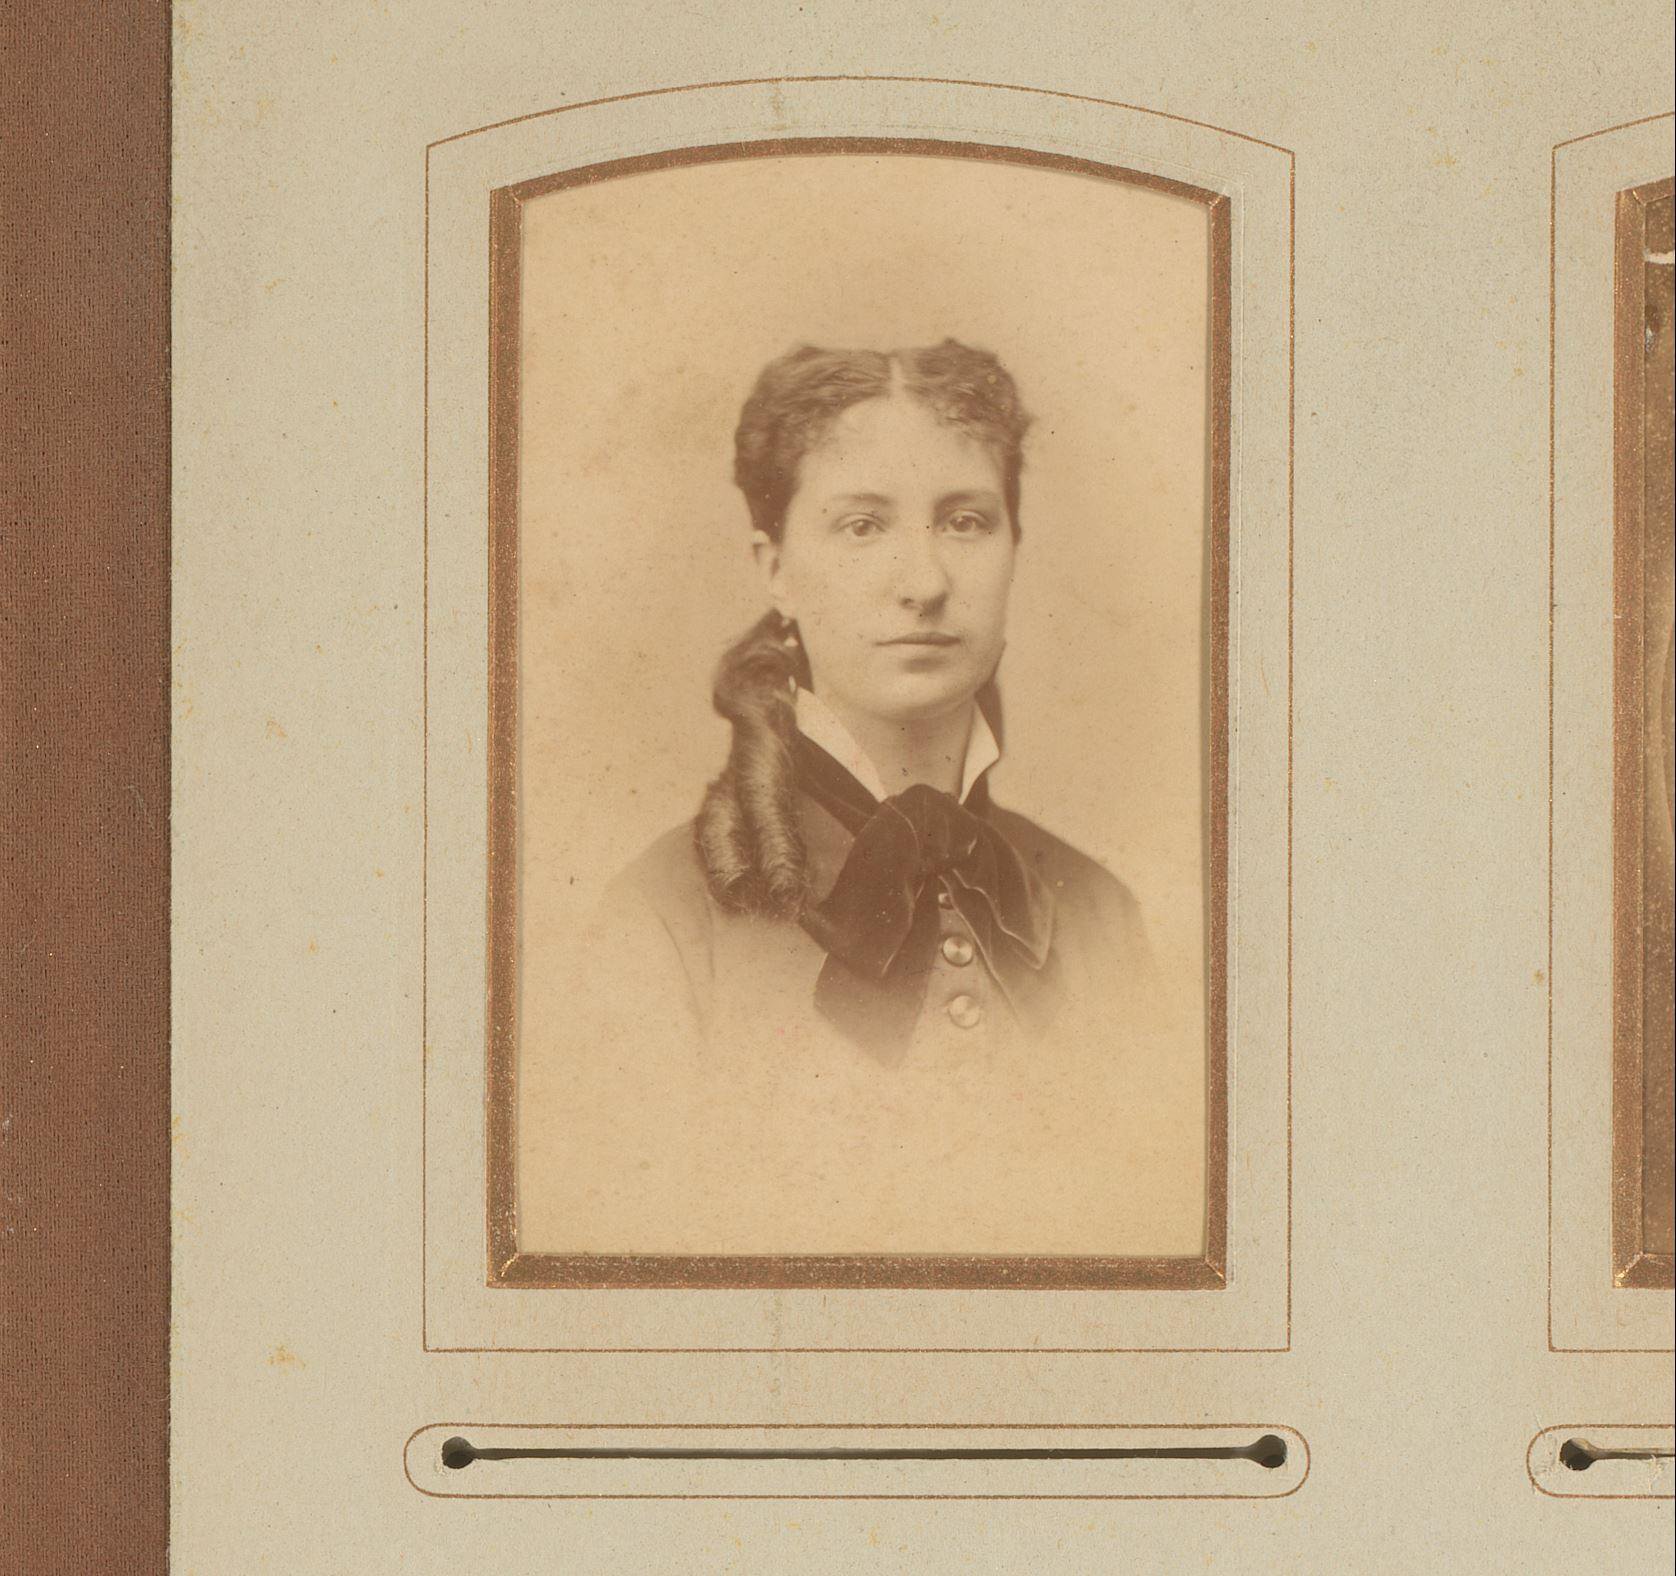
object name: album leaf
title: Portret van een vrouw met pijpenkrullen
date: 1875-1899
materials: cardboard, photographic support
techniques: albumen print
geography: amsterdam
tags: historical persons - bb - woman, hairdress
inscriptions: inscription: ‘Photographie Artistique/ Photographie Française/ Warmoesstraat 147 Amsterdam.’